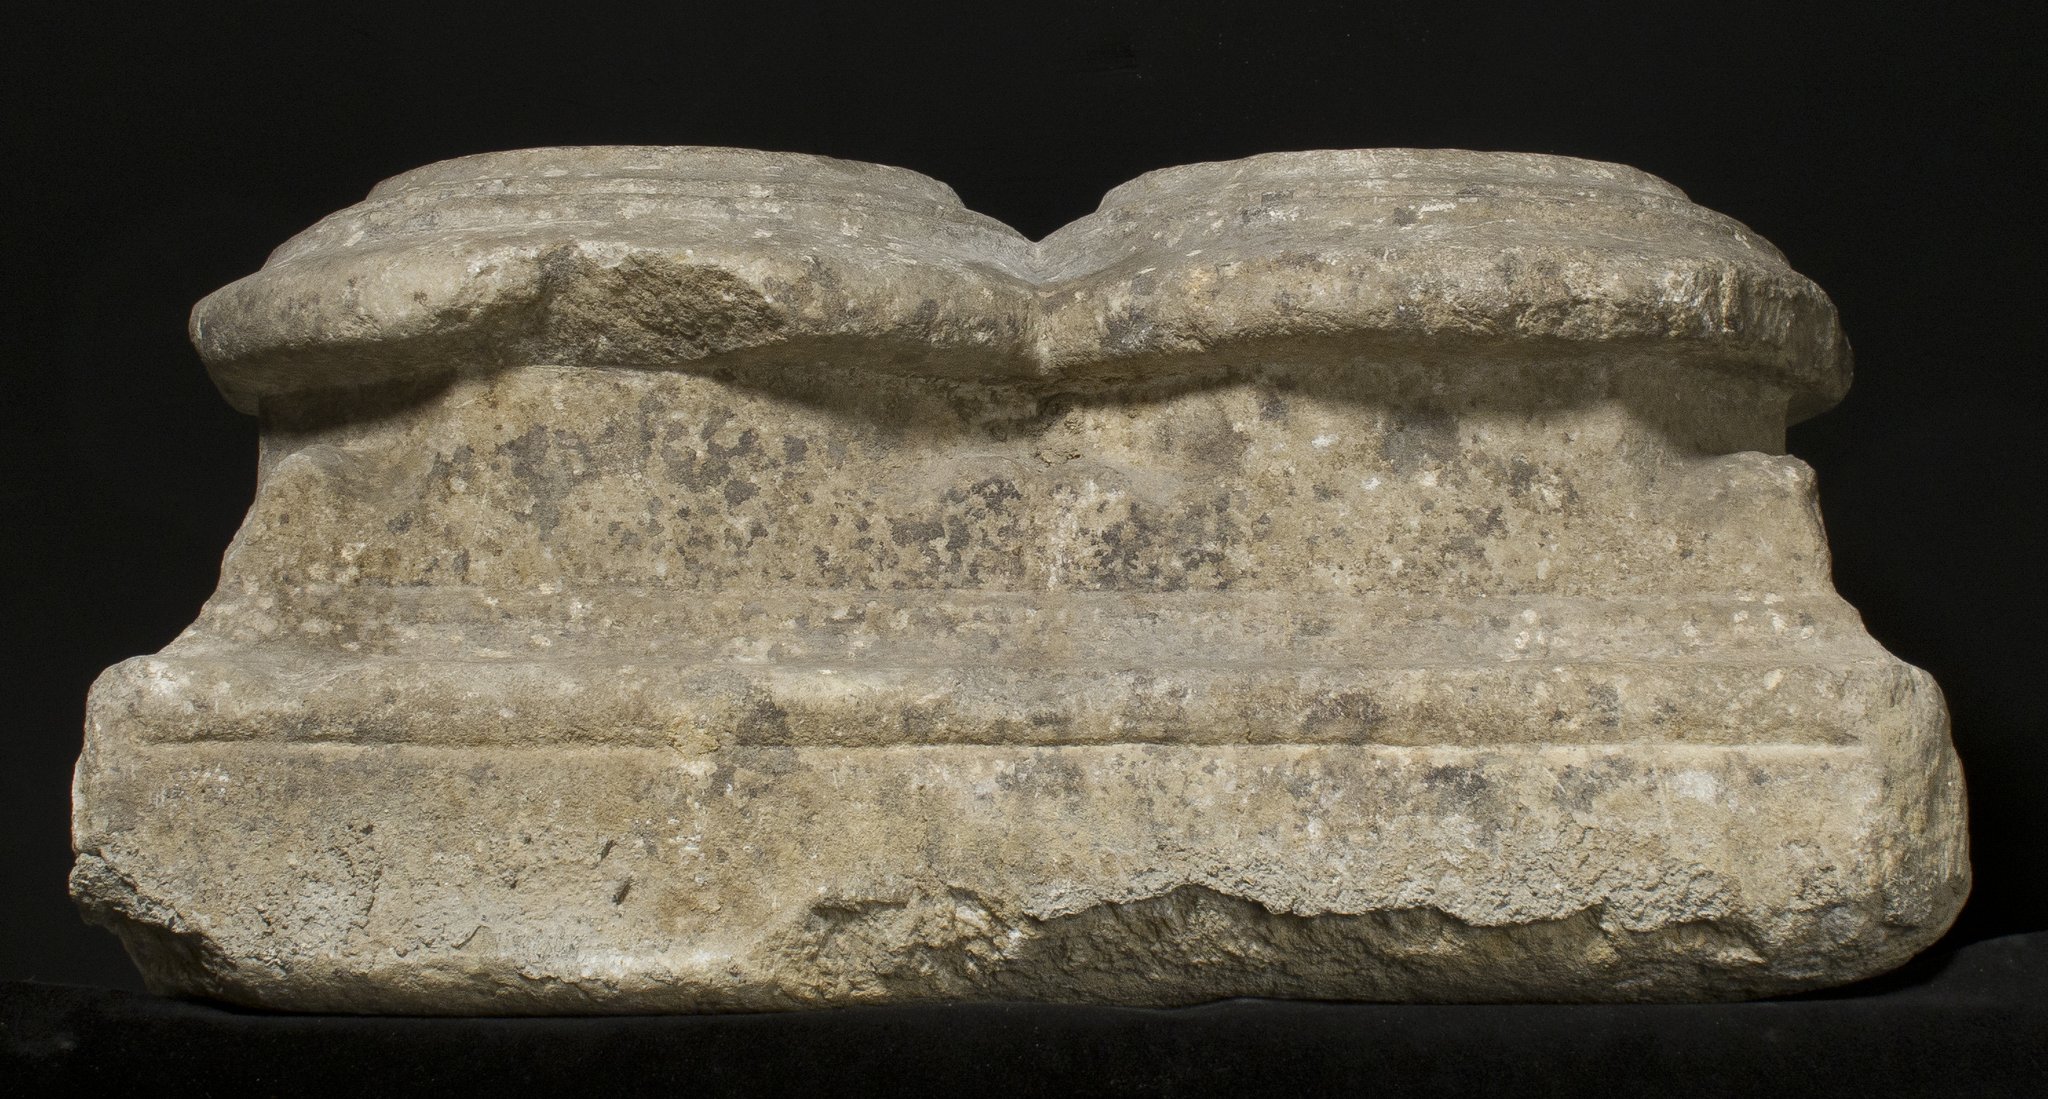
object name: base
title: Double Column Base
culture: french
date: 1201-1400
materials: limestone, stone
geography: france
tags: architecture